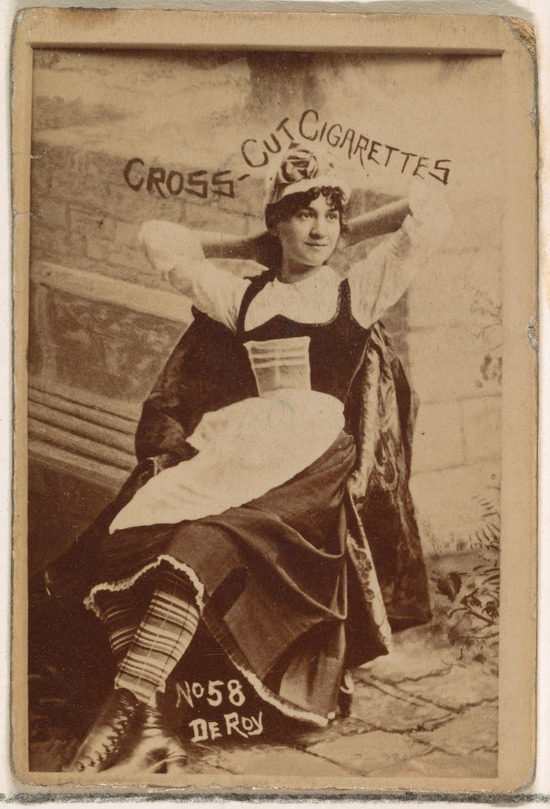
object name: print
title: Card Number 58, De Roy, from the Actors and Actresses series (N145-1) issued by Duke Sons & Co. to promote Cross Cut Cigarettes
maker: w. duke, sons & co.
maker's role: publisher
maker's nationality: american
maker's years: 1870-1920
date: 1880-1889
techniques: albumen silver print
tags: portraits,women,actresses